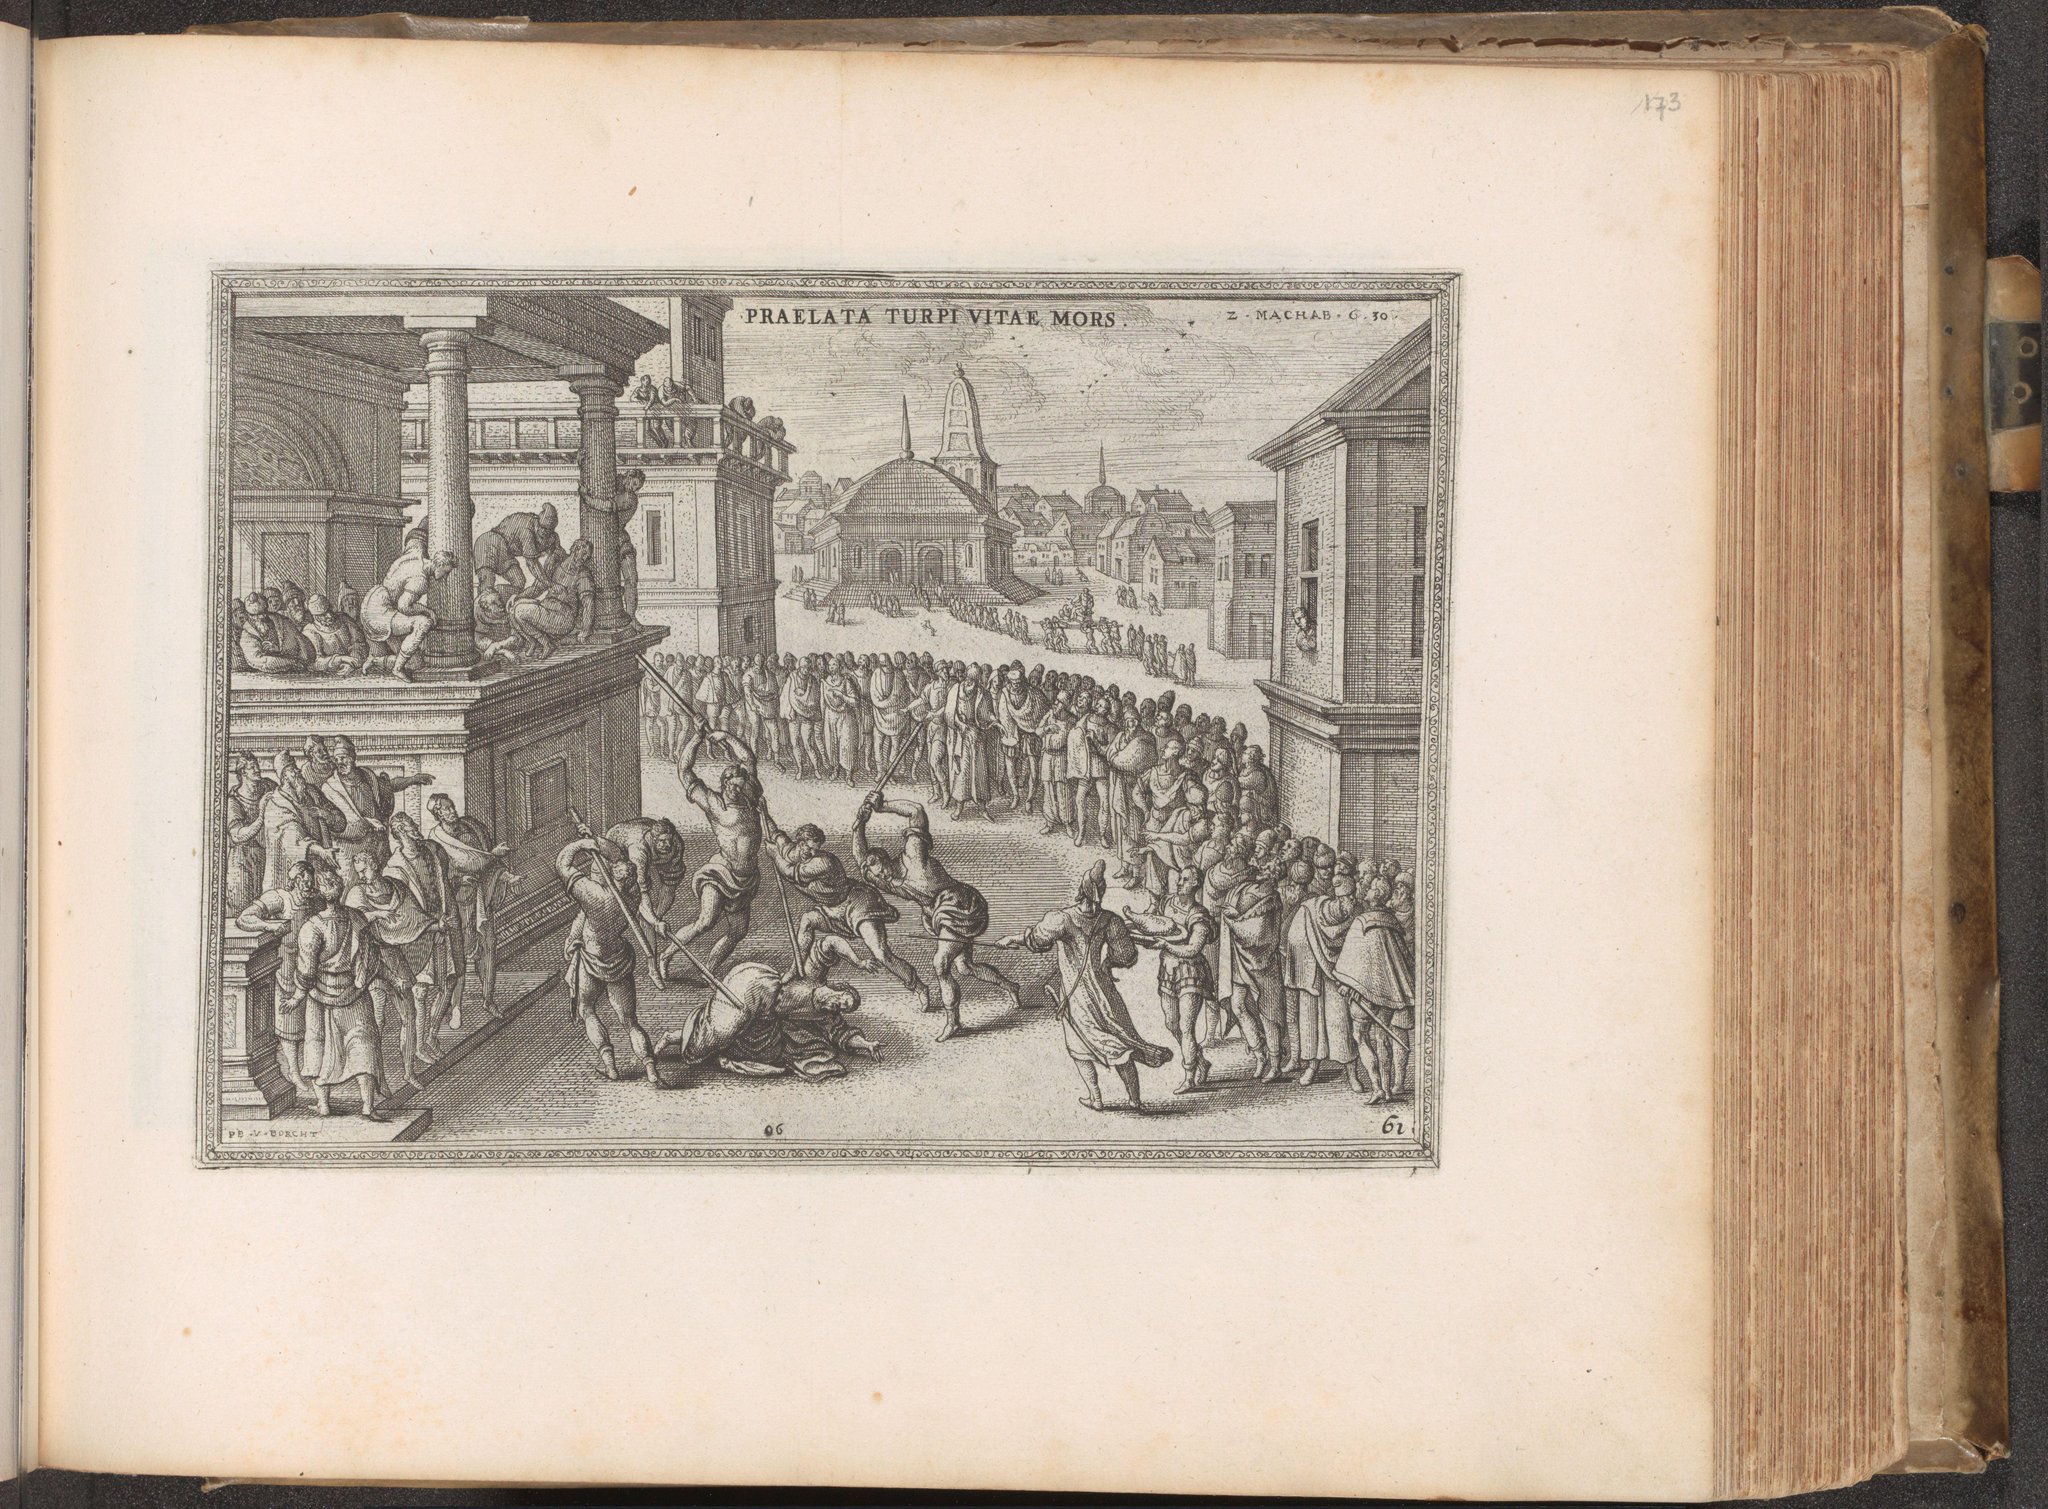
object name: print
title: Den Grooten Emblemata Sacra, bestaande in meer dan vier hondert bybelsche figuren, zoo des Ouden als des Nieuwen Testaments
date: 1582-1593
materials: paper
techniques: etching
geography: amsterdam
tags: martyrdom of eleazar: the old man is forced to eat pork and voluntarily submits to the flogging (2 maccabees 6:18-31)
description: Eleazar wordt doodgeslagen in opdracht van Antiochus omdat hij weigerde varkensvlees te eten (2. Makk. 6:30). De prent maakt deel uit van een album.